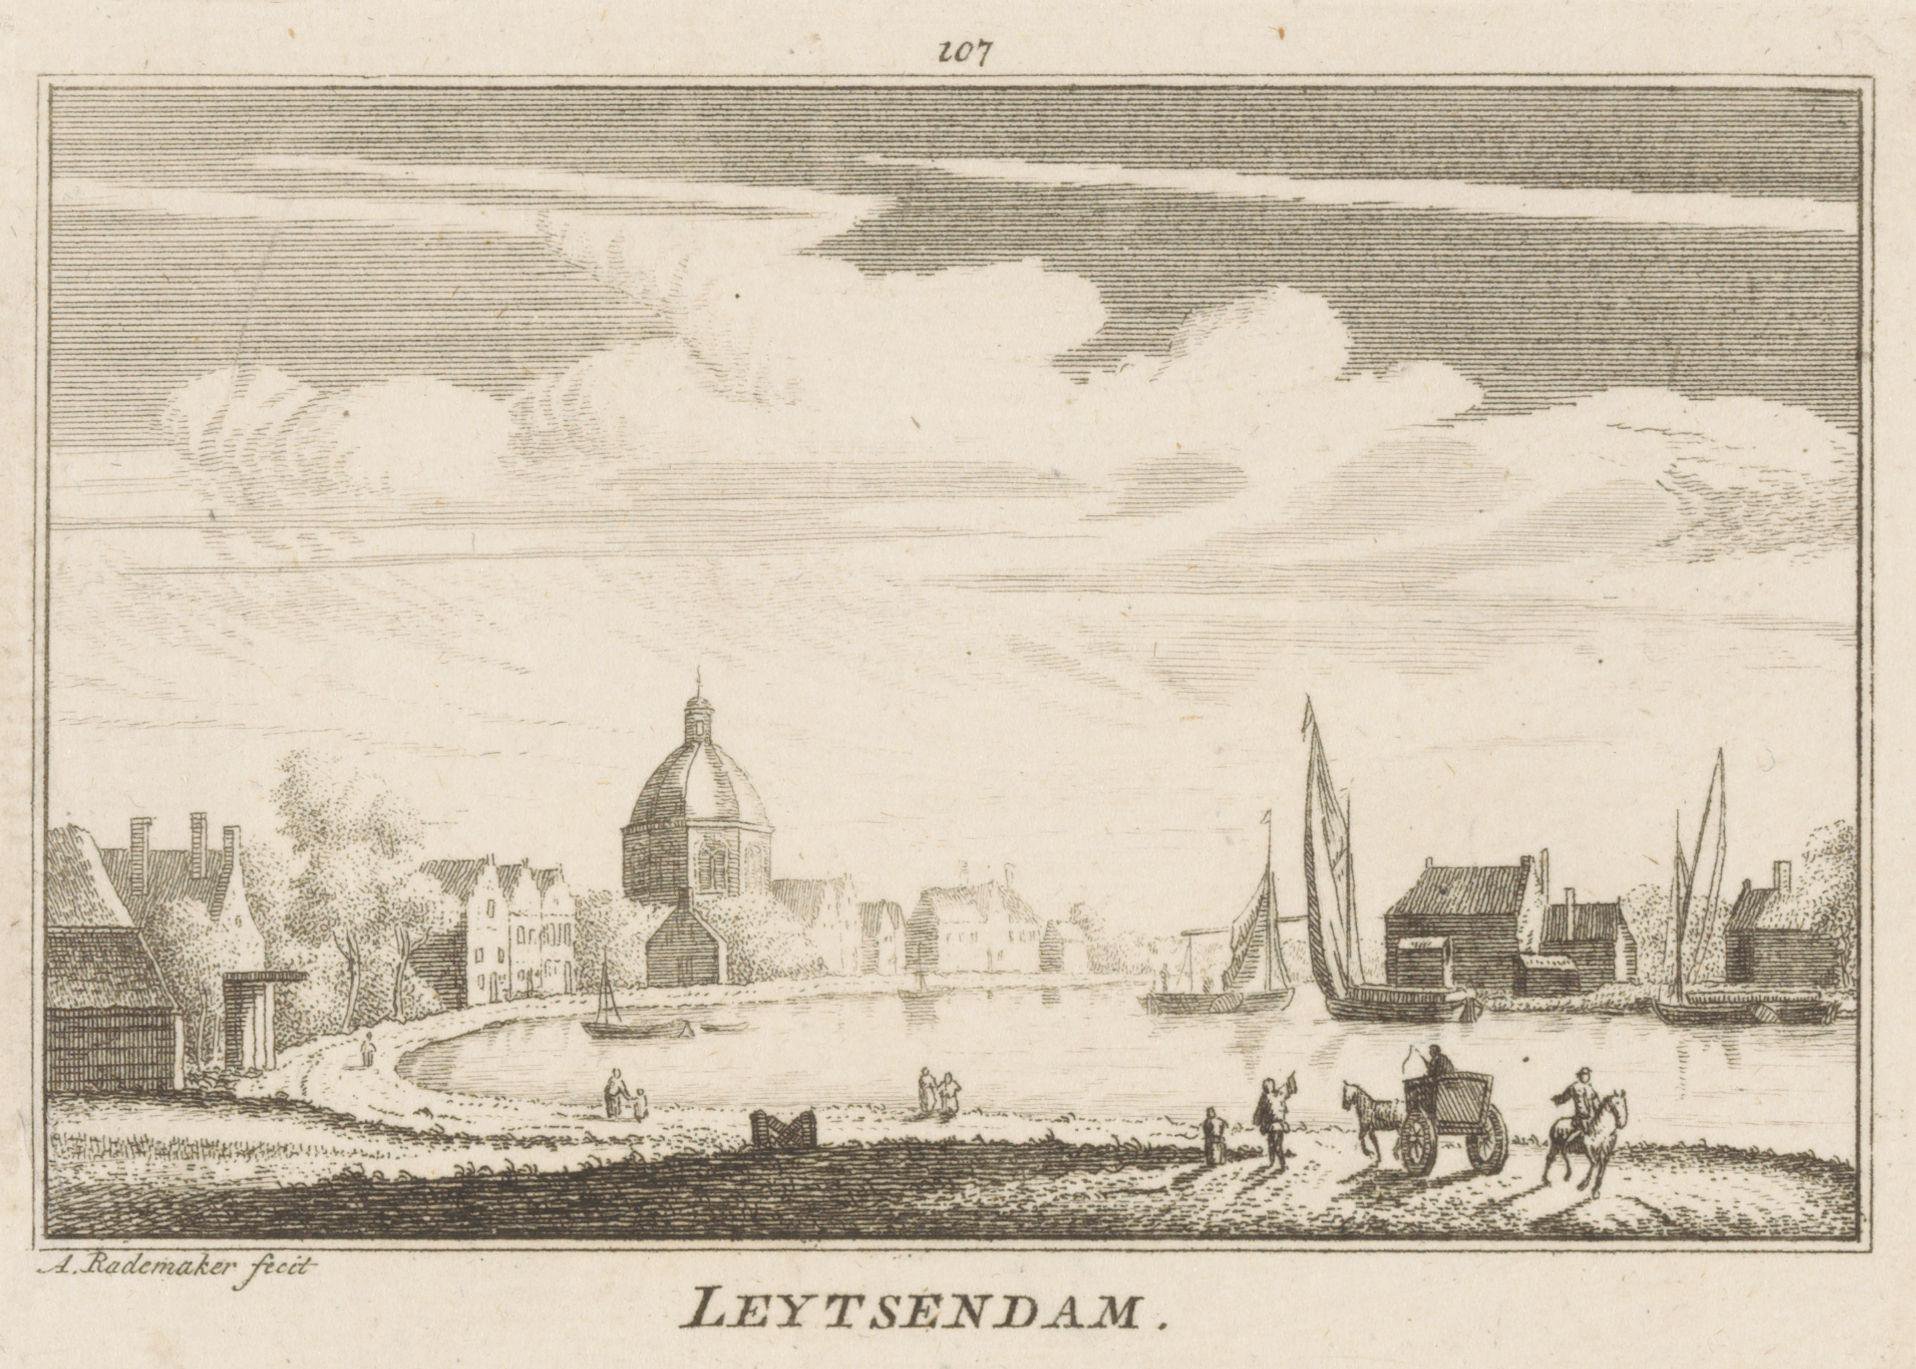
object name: book illustration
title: Leytsendam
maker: abraham rademaker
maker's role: draughtsman, print maker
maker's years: 1676-1735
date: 1725-1803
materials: paper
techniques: engraving, etching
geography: amsterdam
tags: prospect of village, silhouette of village, sailing-ship, sailing-boat, church (exterior)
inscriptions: collector's mark: Lugt 2228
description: Prent ook gebruikt in: Rademaker, Abraham. Kabinet van Nederlandsche outheden en gezichten: vervat in 300 konstplaaten (…). 2 delen. Amsterdam: Willem Barents, 1725, dl. 1, ill. 107. Na 1725 is deze prent nog in verschillende heruitgaven verschenen, uitgegeven in 1727-1733, 1770-1771 en 1792-1803. Uit welke uitgave het huidige exemplaar precies komt is niet na te gaan.